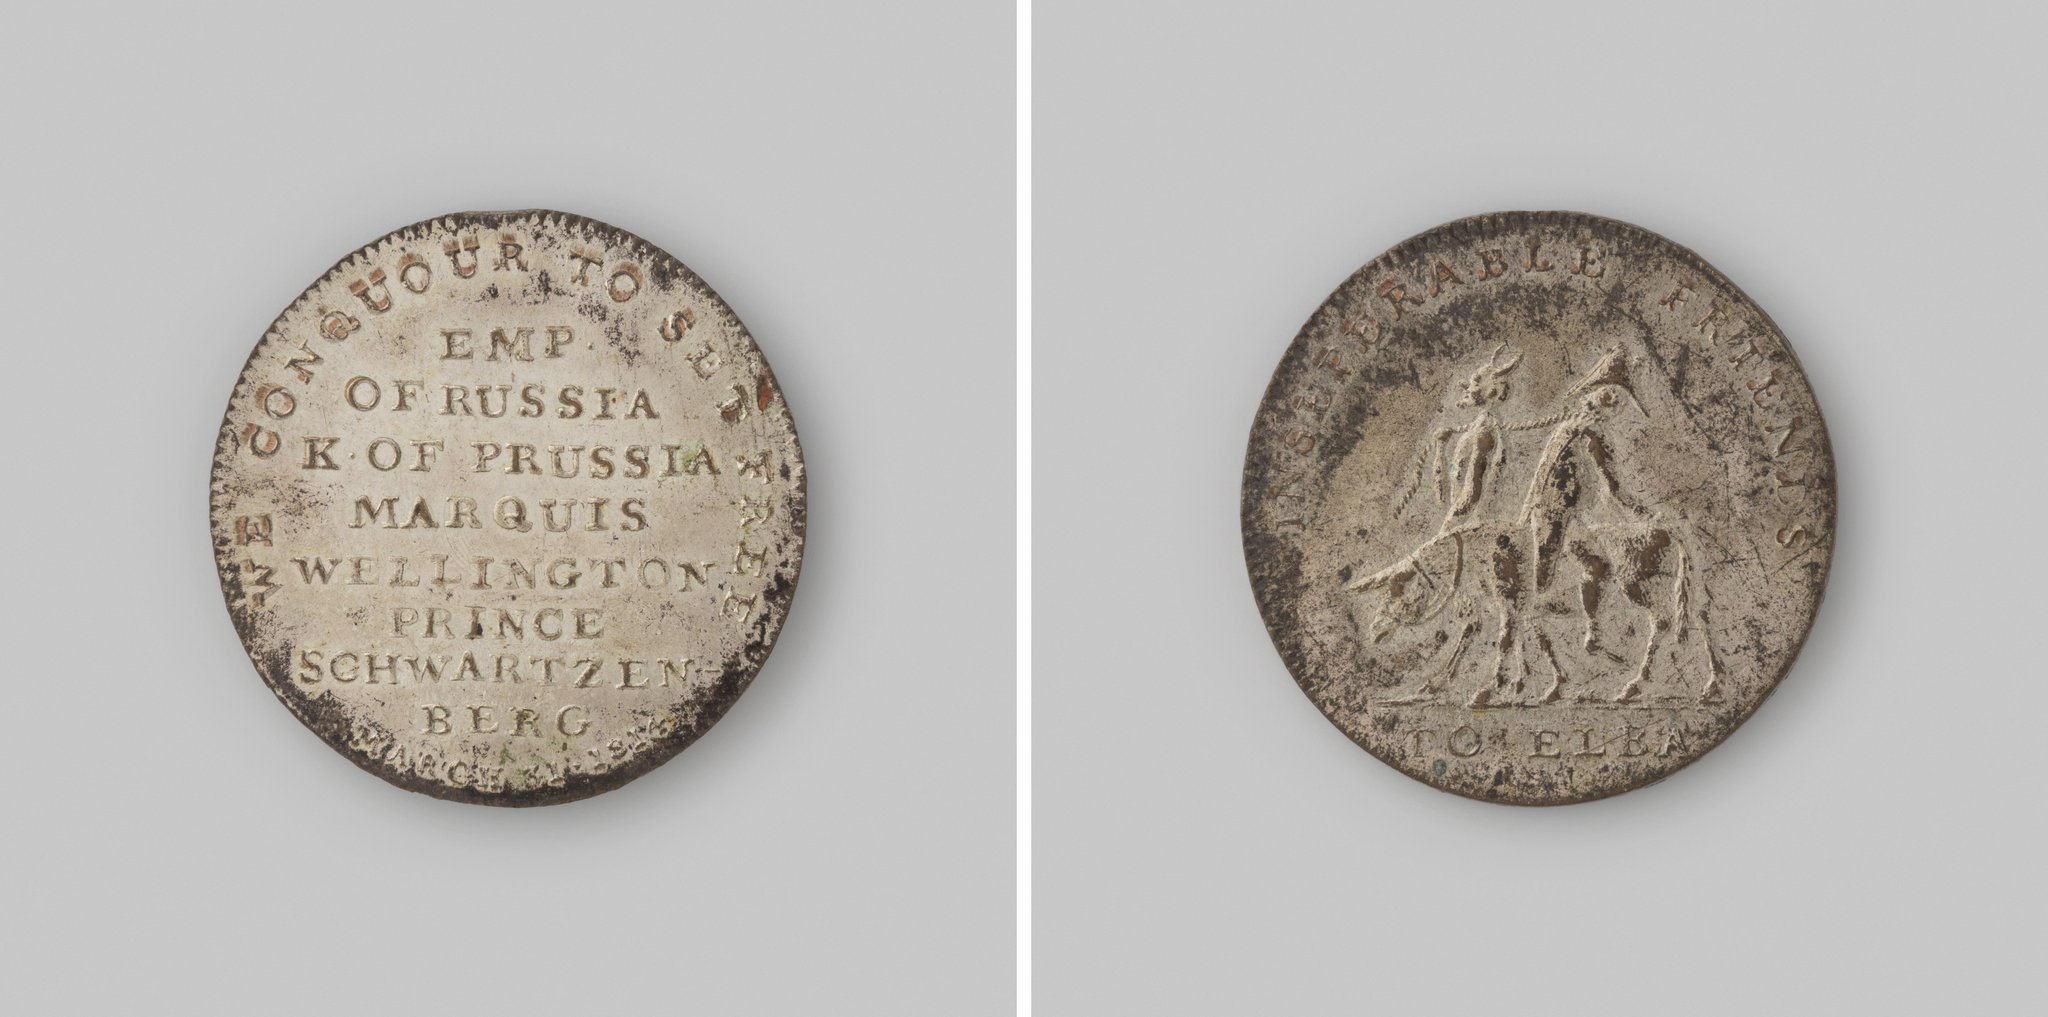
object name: history medal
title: Spotpenning op de verbanning van Napoleon naar Elba 1814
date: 1814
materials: brass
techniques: striking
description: Verzilverde penning, op de voorzijde Satan die Napoleon, achterstevoren op een ezel zittend, wegleidt, met omschrift en afsnedetekst, op de keerzijde acht regels tekst met omschrift.